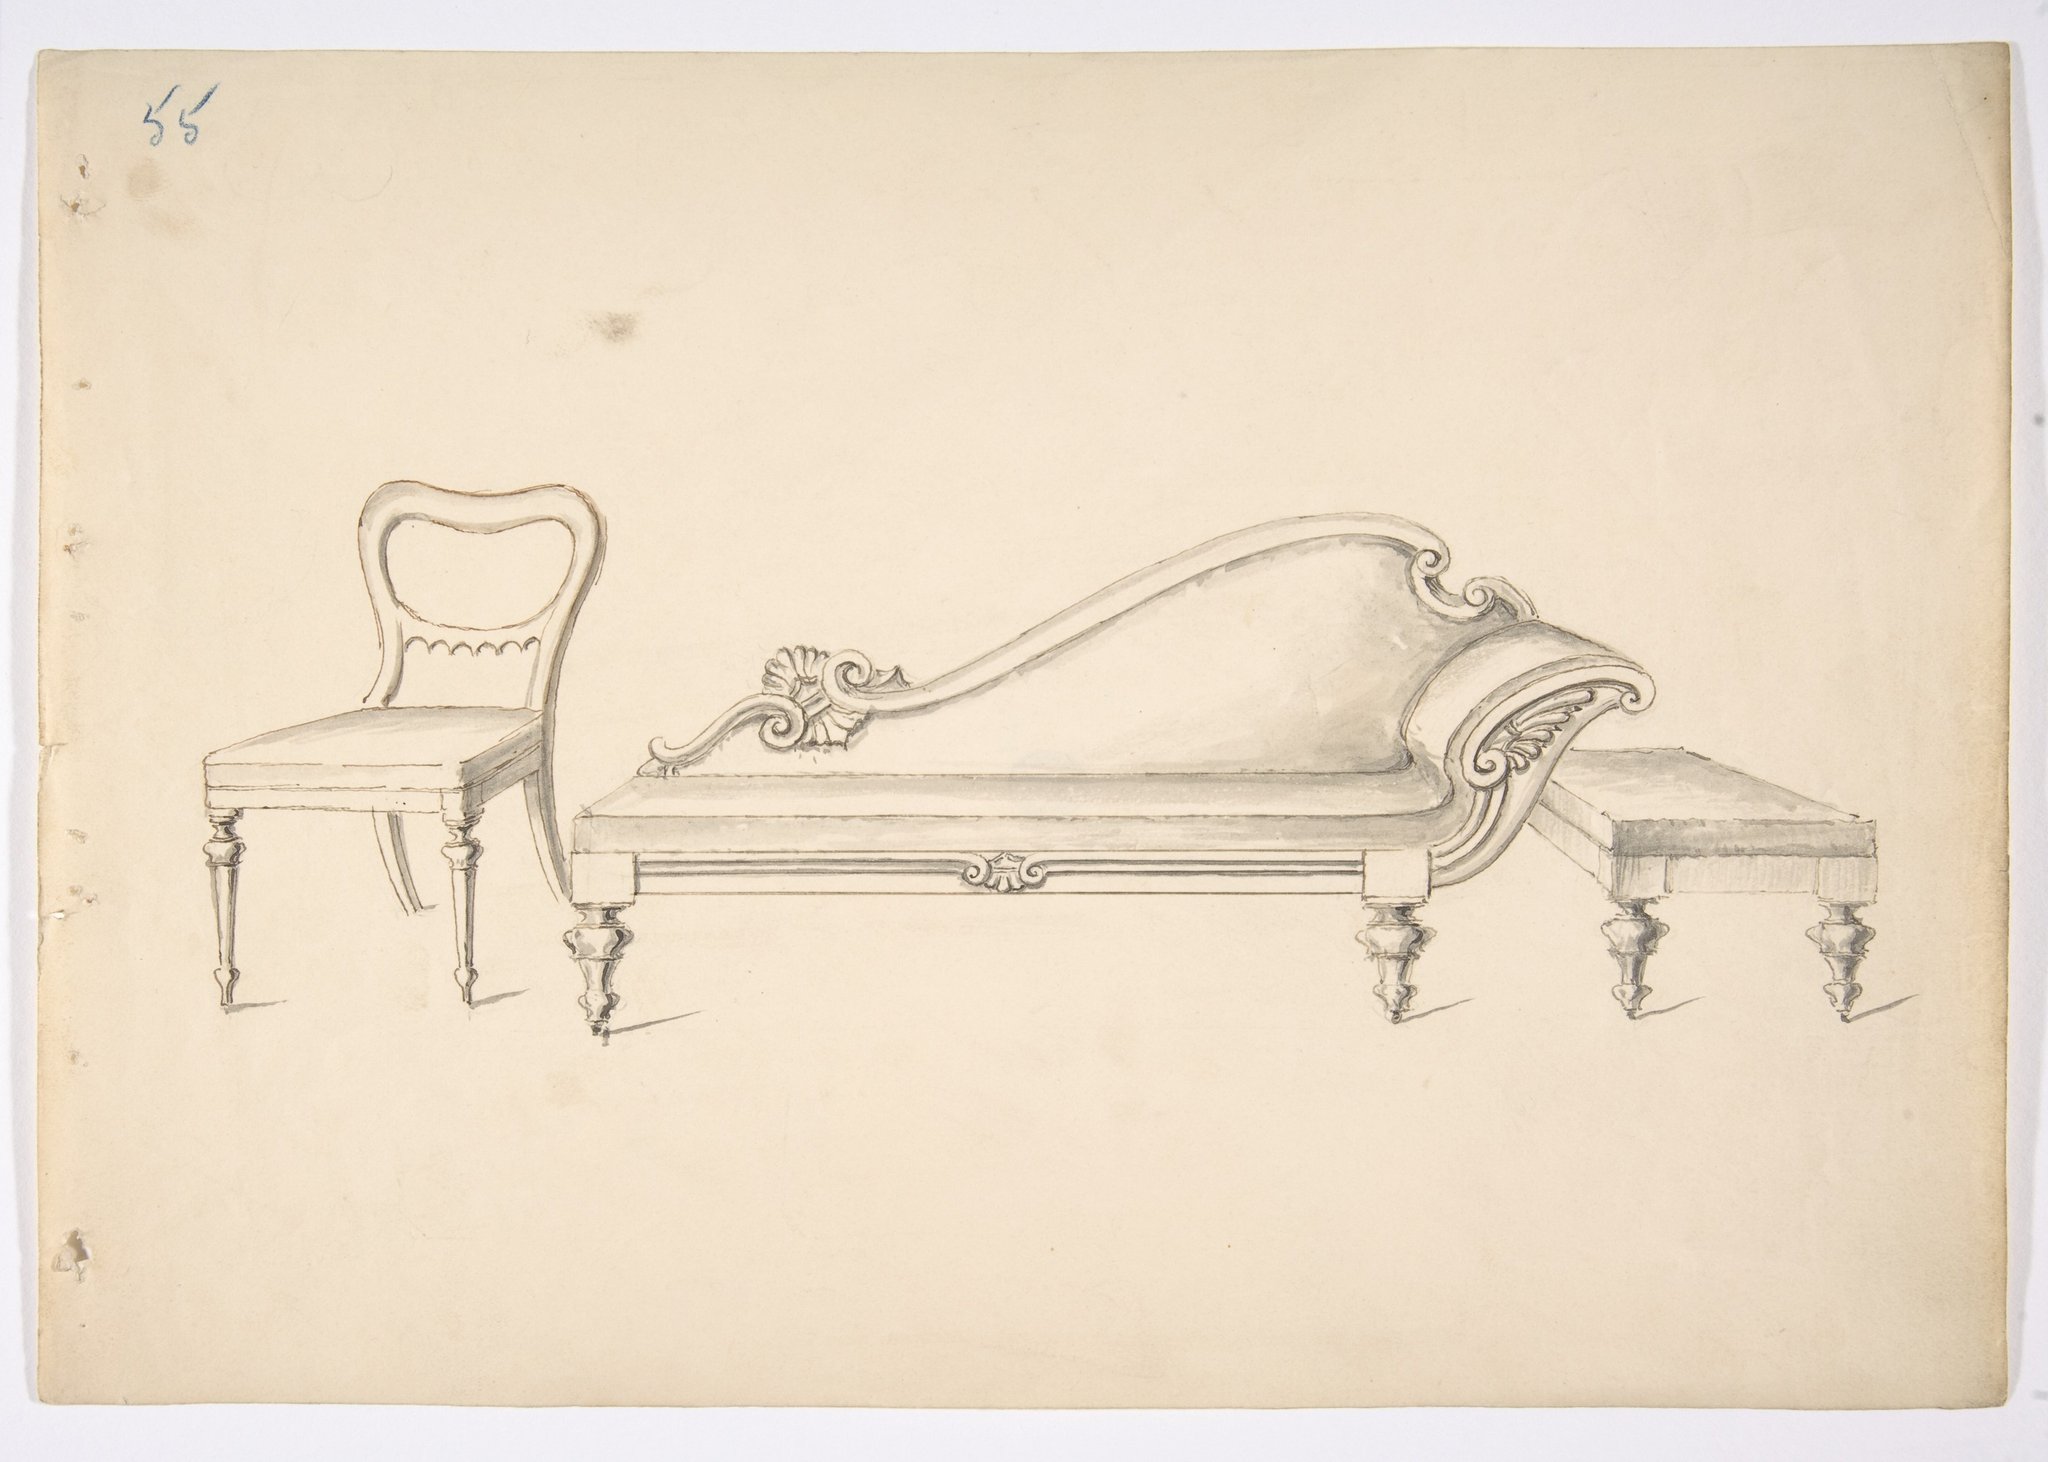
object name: drawing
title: Design for a Sofa with One WIng-like Arm, Chair and Stool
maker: anonymous, british, 19th century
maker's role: artist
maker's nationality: british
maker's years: 1800-1900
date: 1801-1833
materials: graphite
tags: chairs,stools